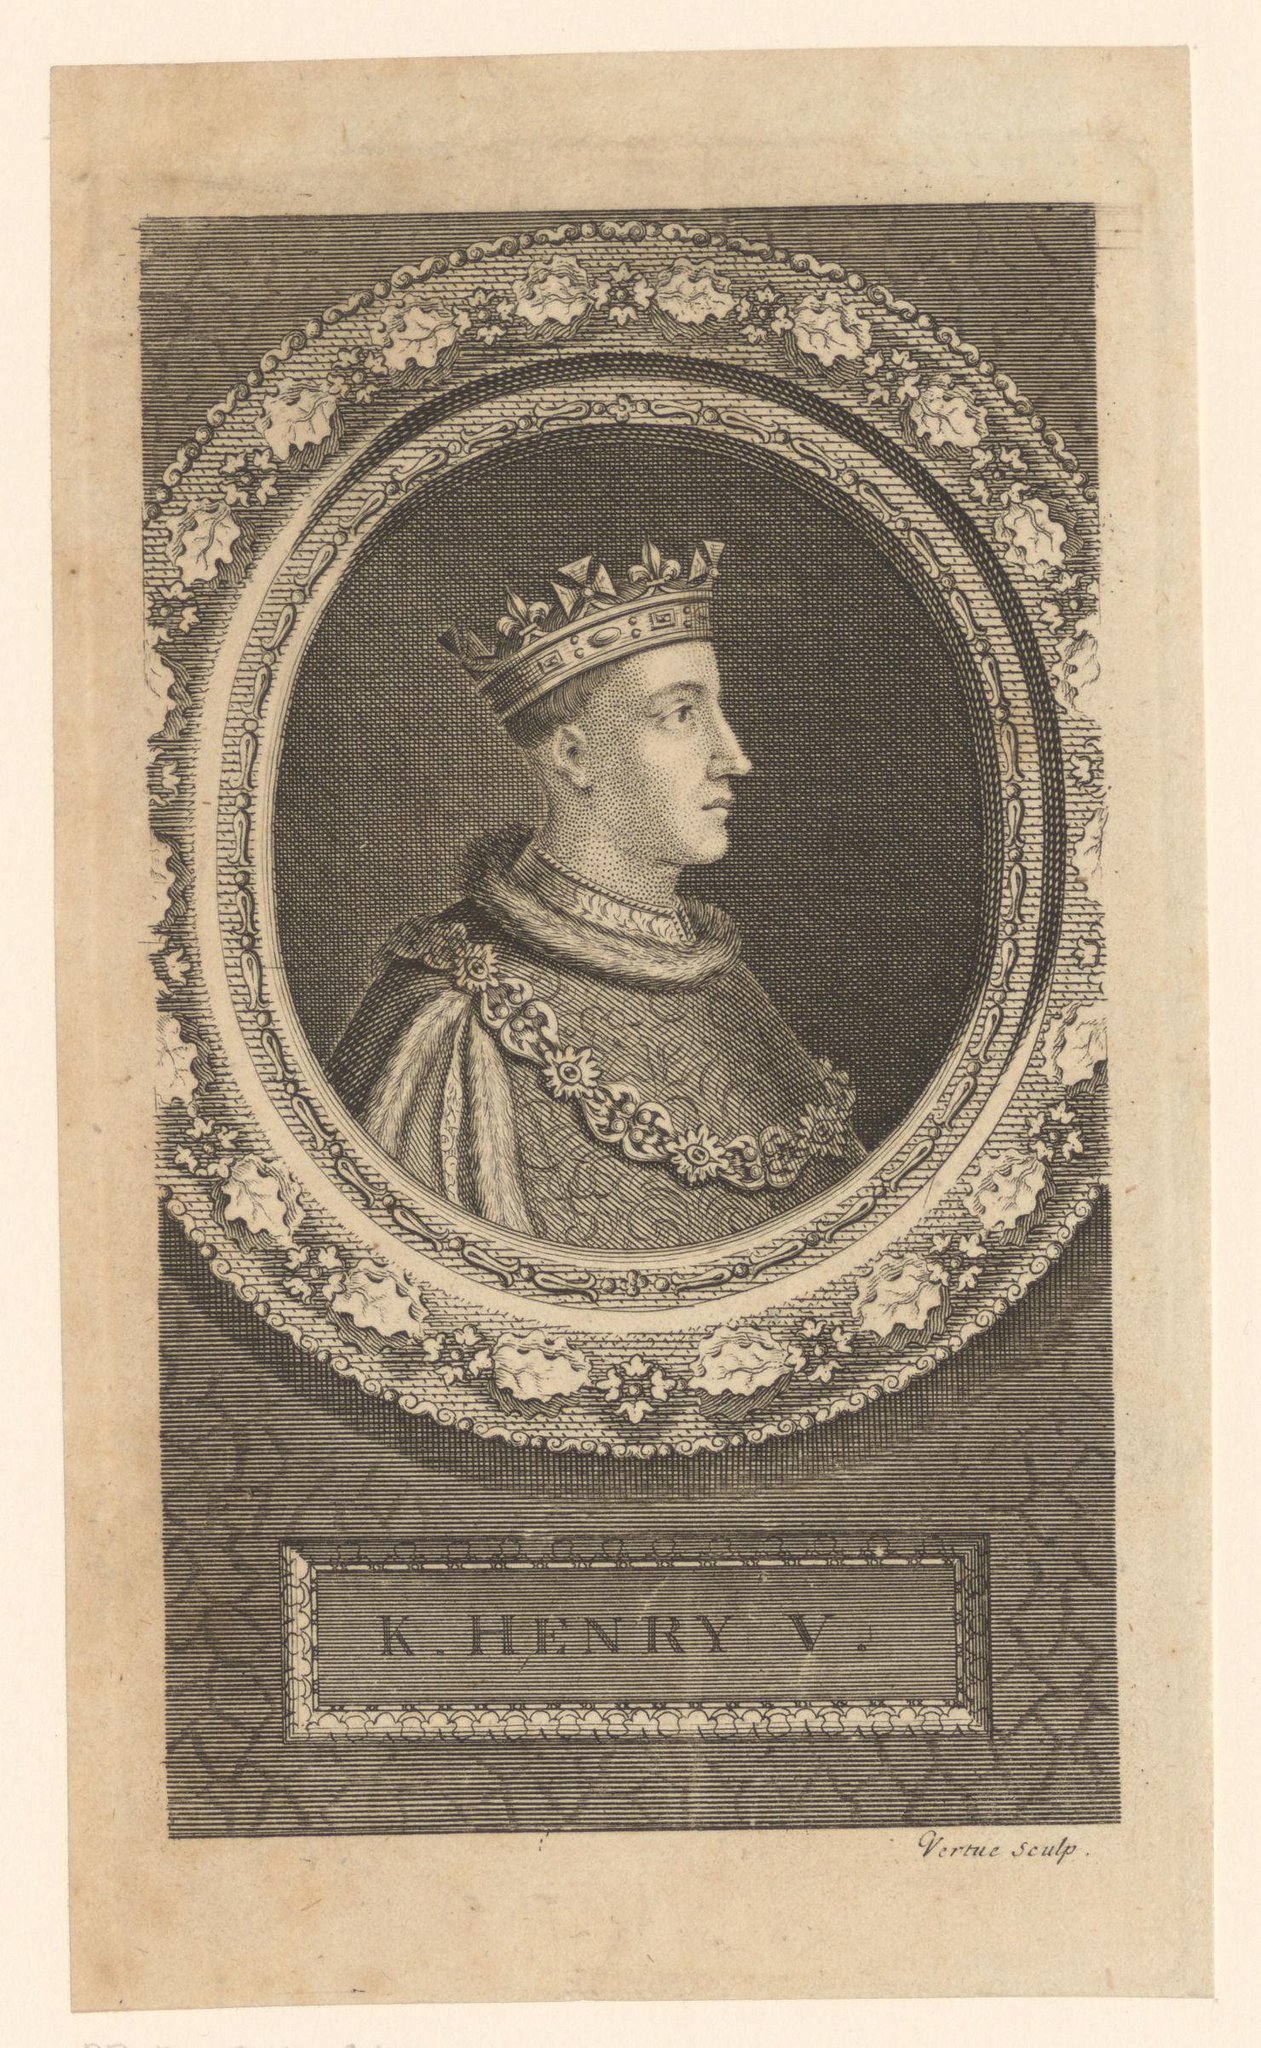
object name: print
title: Portret van Hendrik V, koning van Engeland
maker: george vertue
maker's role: print maker, publisher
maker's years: 1684-1756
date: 1694-1756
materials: paper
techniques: engraving, etching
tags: historical persons, king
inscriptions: collector's mark: Lugt 2228